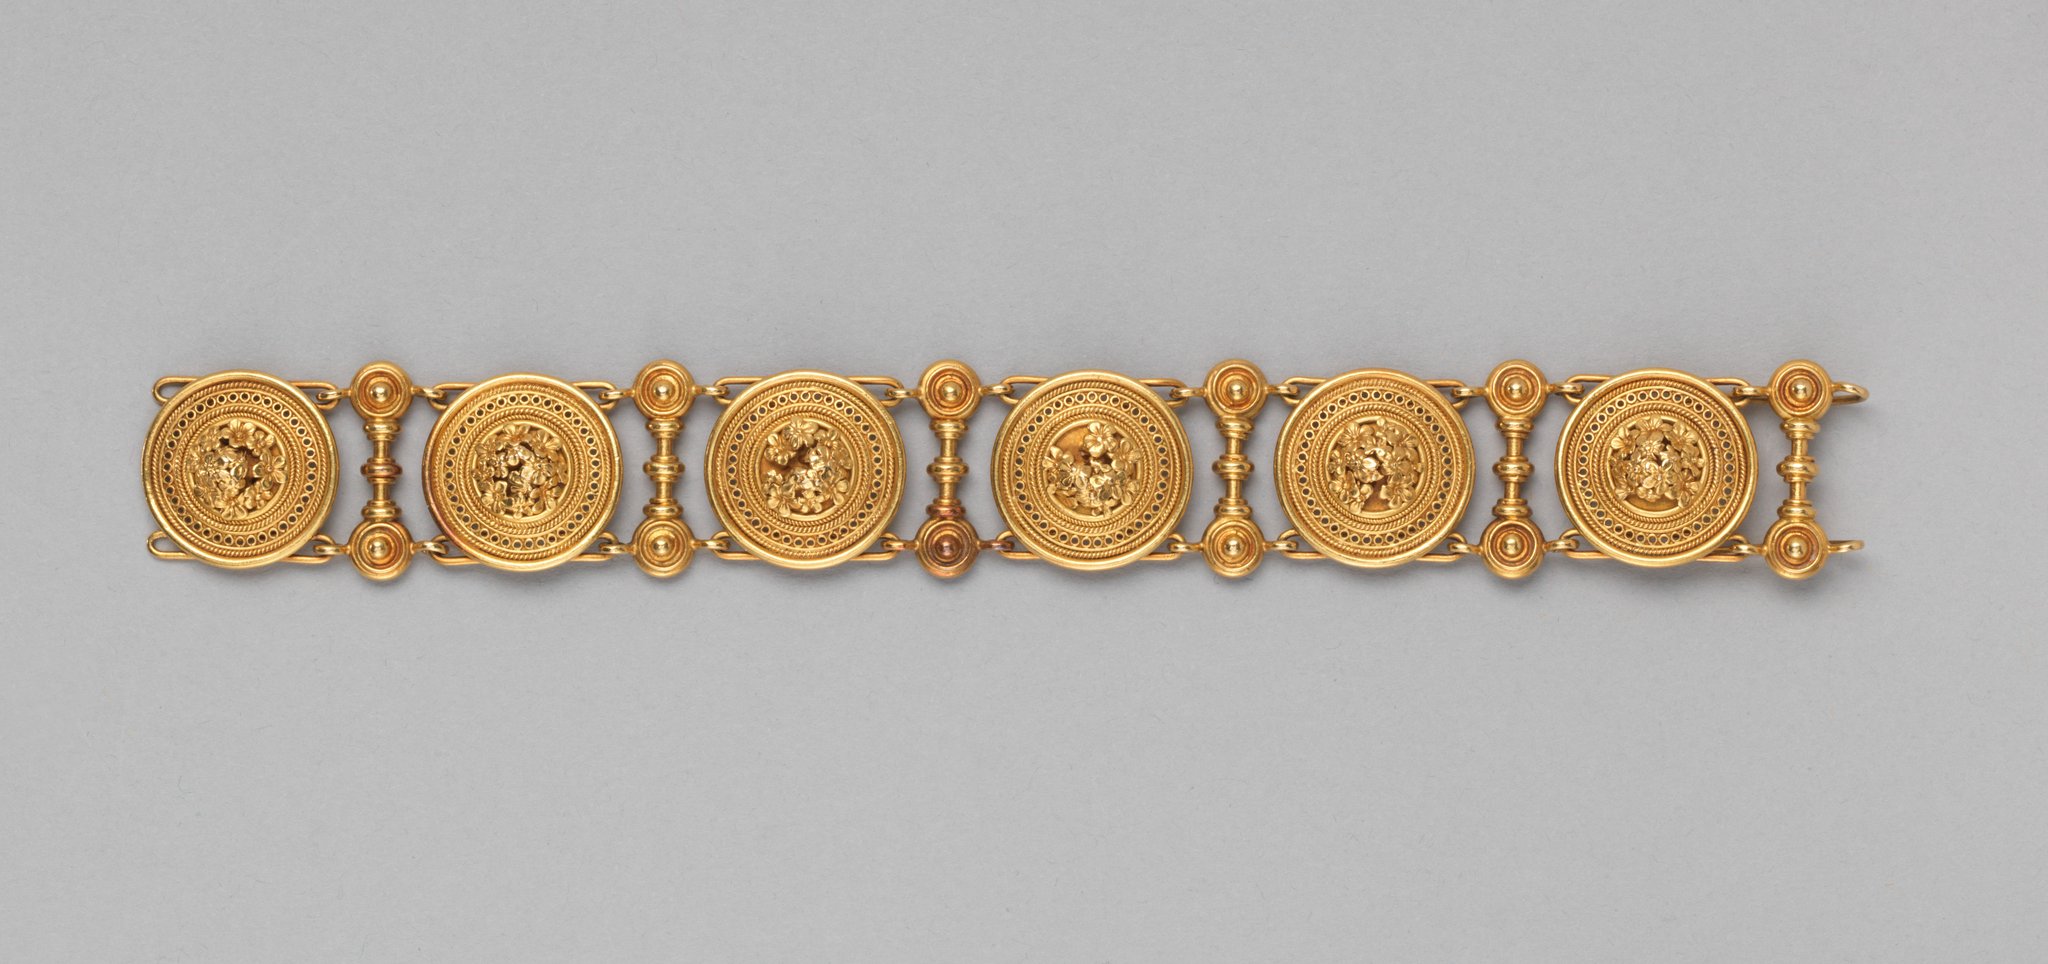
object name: bracelet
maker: castellani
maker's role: maker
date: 1860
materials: gold